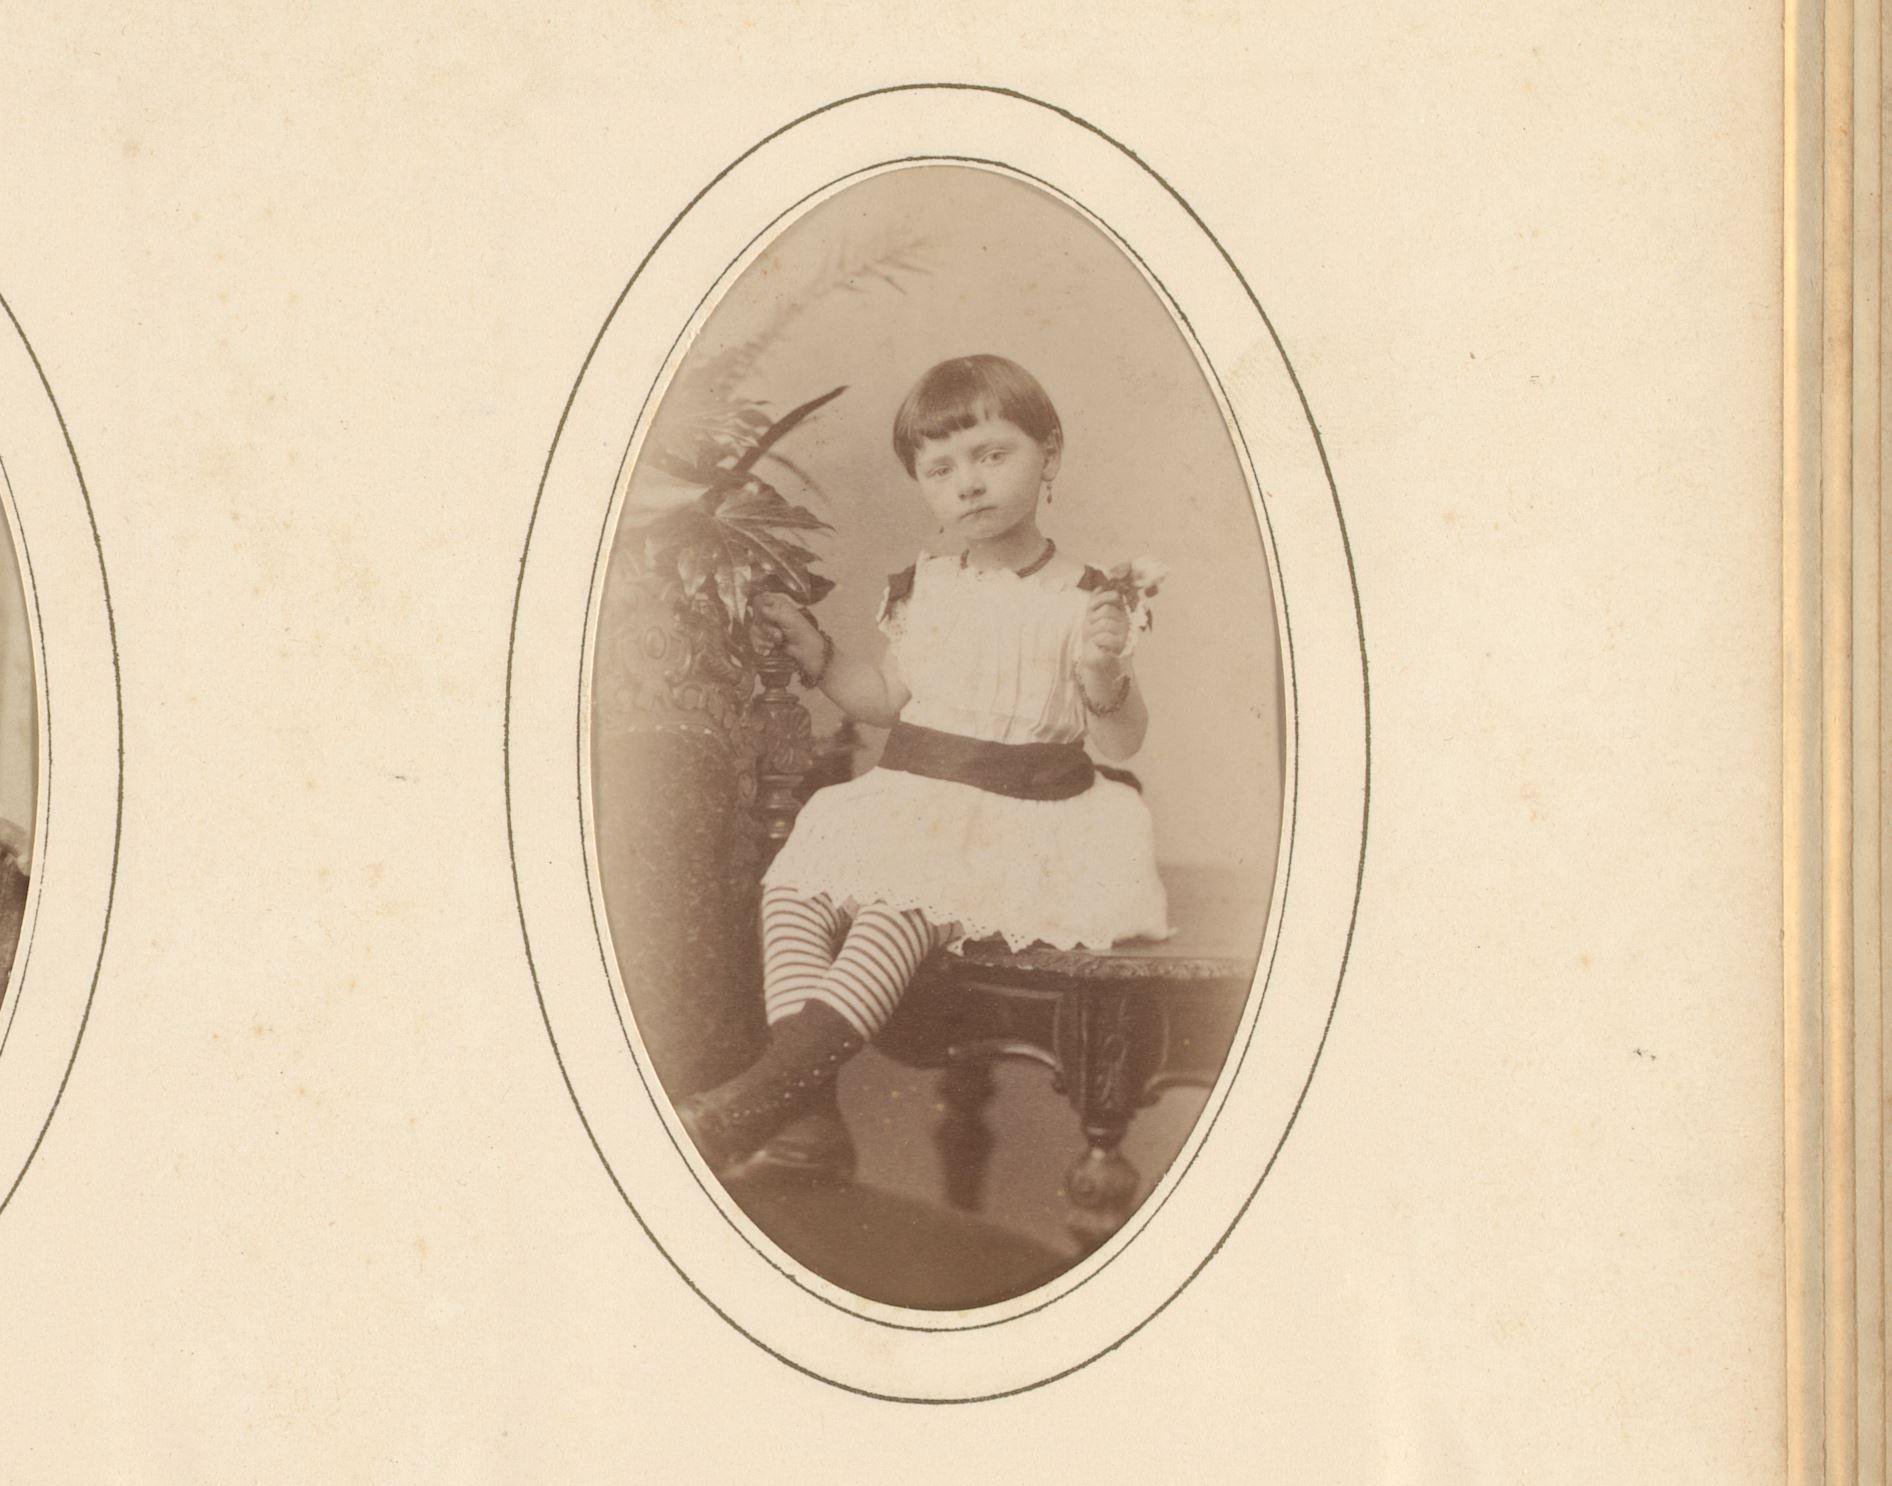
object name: photograph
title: Portret van een meisje, zittend op een tafel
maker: friedrich carel hisgen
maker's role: fotograaf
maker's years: 1846-1912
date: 1886-1887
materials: cardboard, photographic support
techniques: albumen print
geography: amsterdam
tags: sitting figure - aa - female human figure, historical persons - bb - woman, girl (child between toddler and youth), chair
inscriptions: inscription: ‘Photographisch/ Atelier/ van/ F. Hisgen/ Parkstraat 25/ Anrhem/ atelier gelijkvloers’